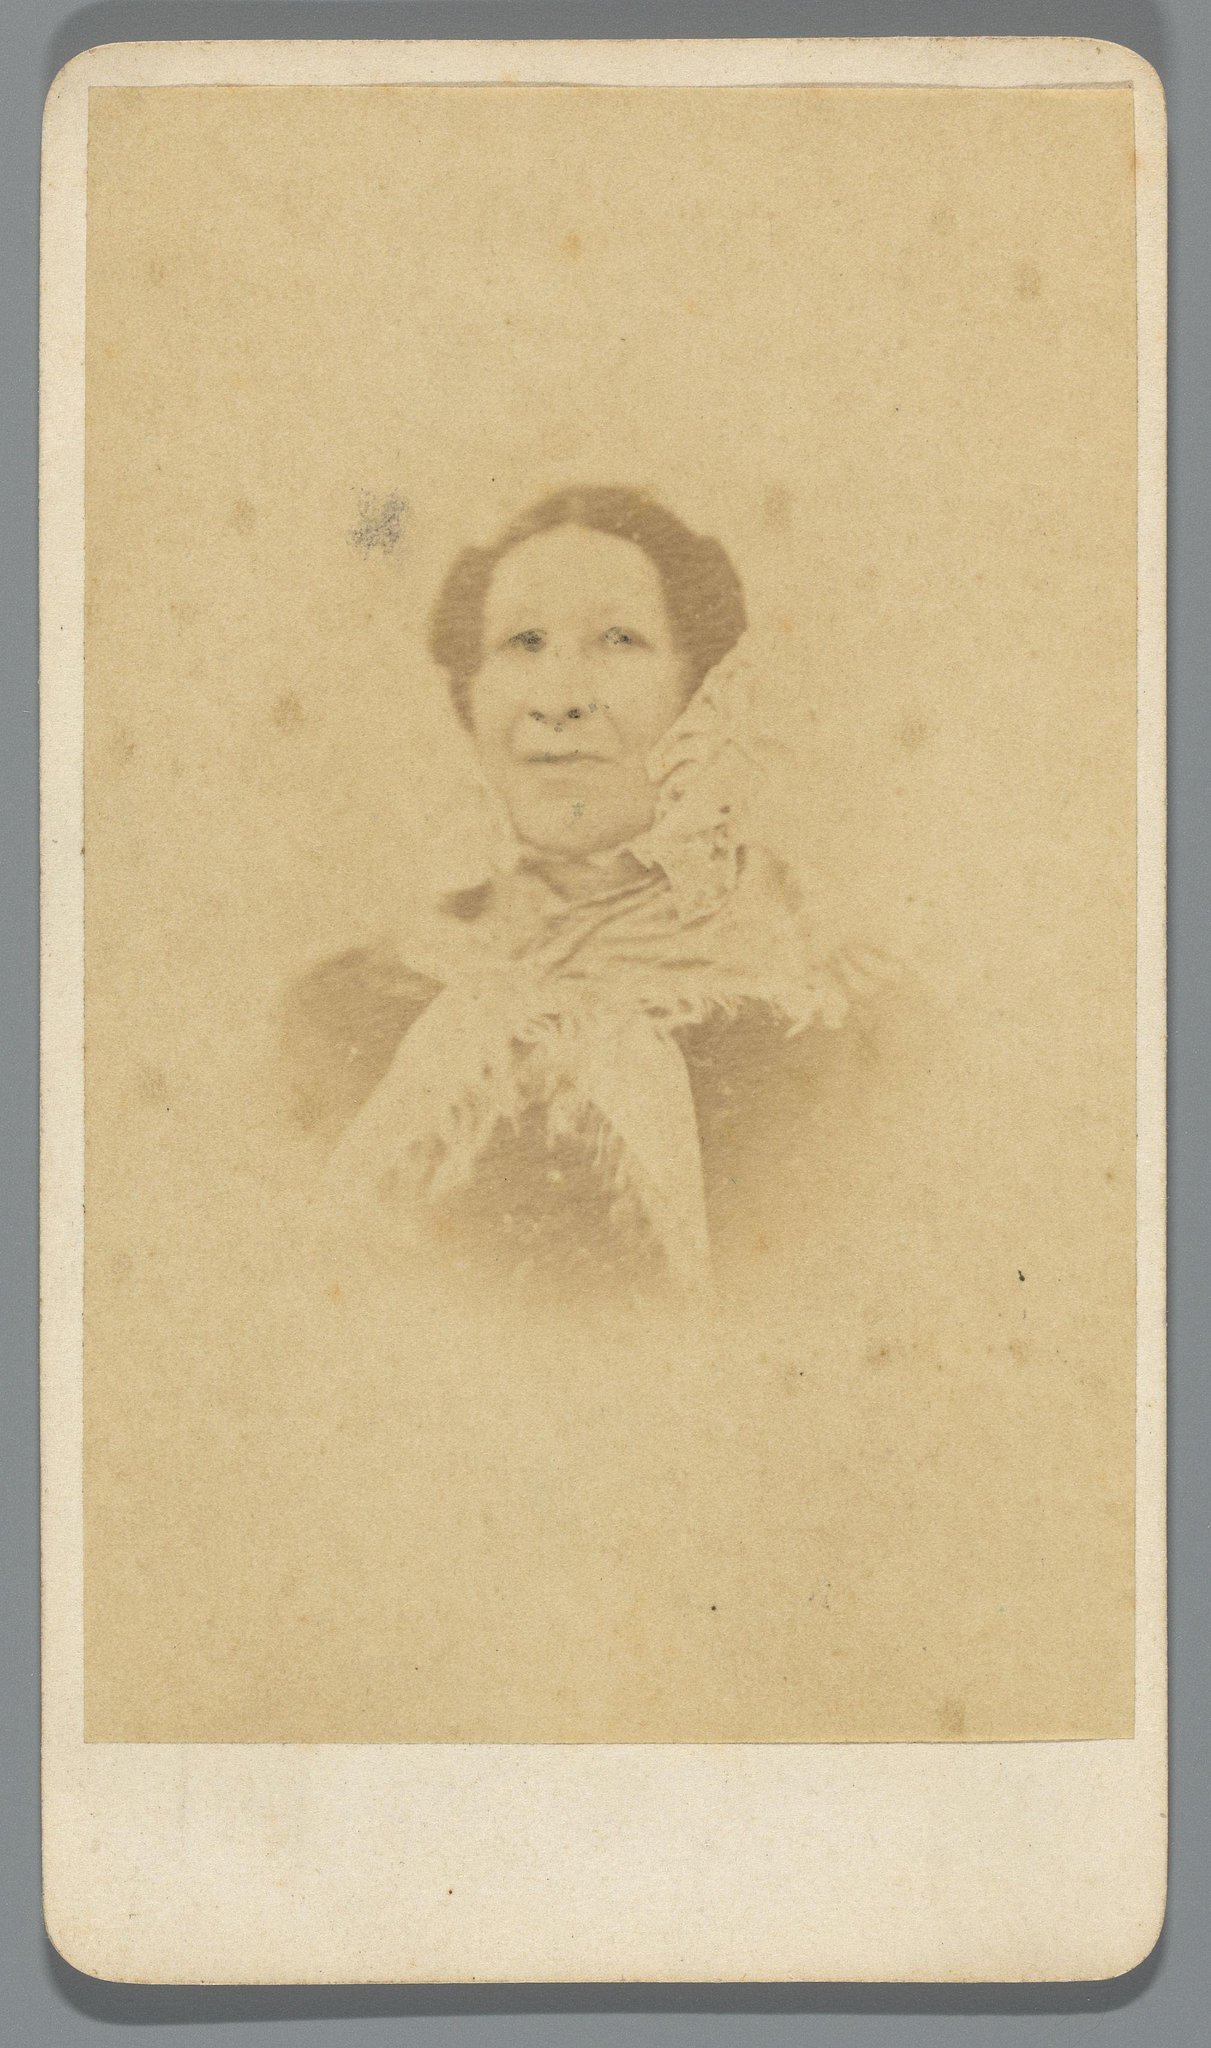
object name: carte de visite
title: Portret van C.F. van der Hucht-van Wijjnbergen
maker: franz wilhelm deutmann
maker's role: fotograaf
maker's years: 1809-1895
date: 1860-1900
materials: cardboard, photographic support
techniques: albumen print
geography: amsterdam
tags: c.f. van der hucht-van wijjnbergen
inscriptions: name: ‘Reproduction / F.W. DEUTMANN / AMSTERDAM.’, name: ‘C.F van der Hucht- / van Wijnbergen’